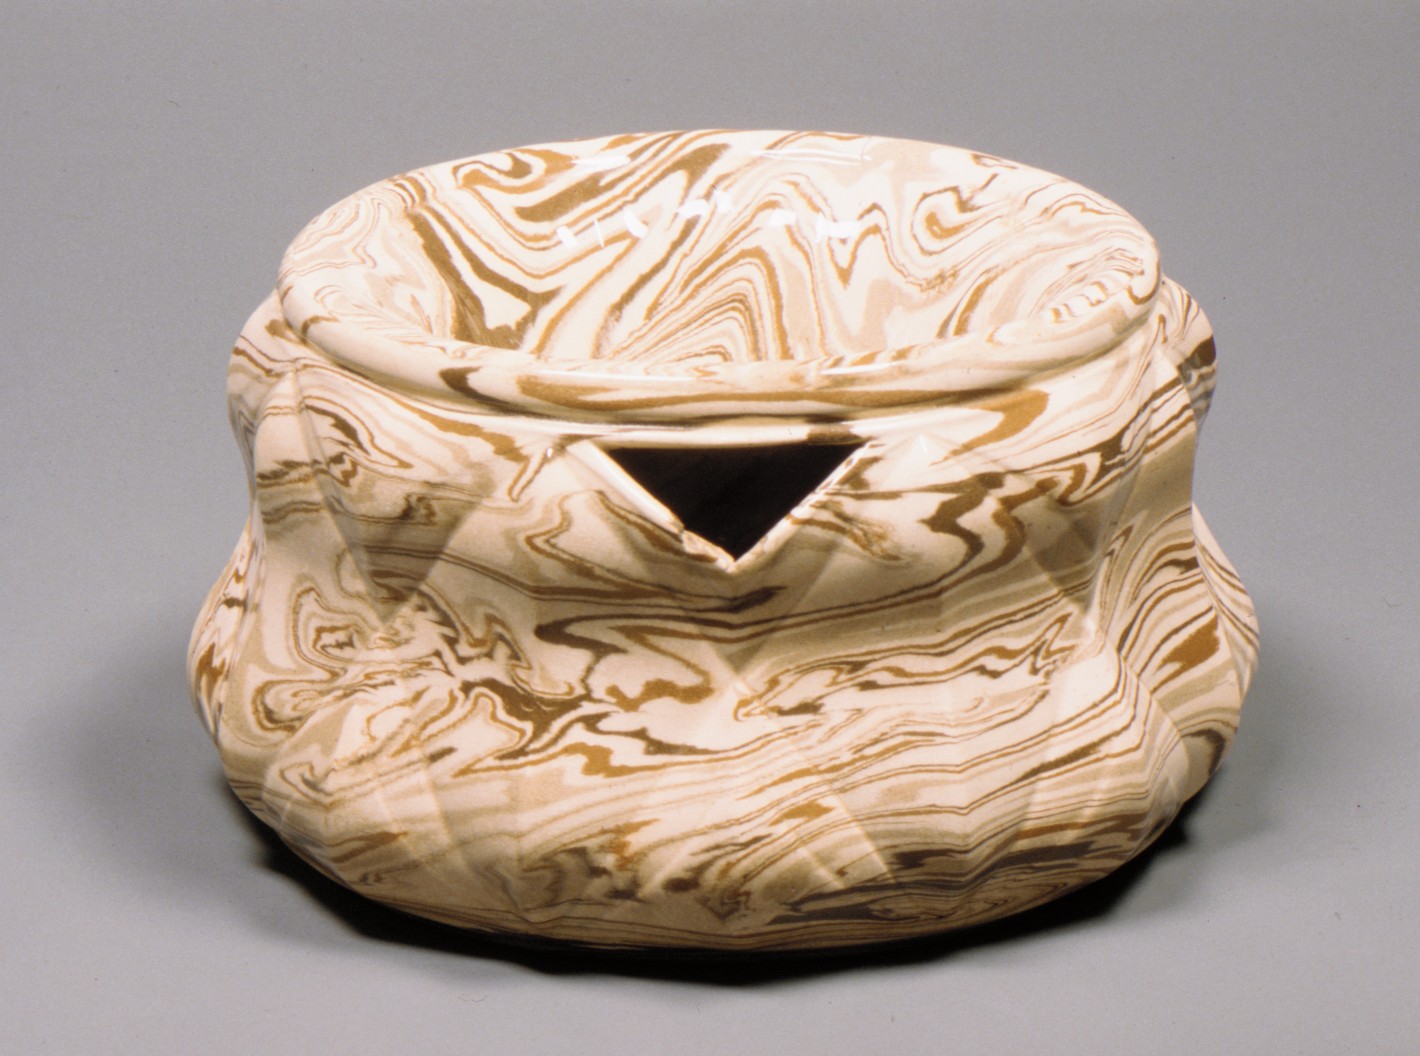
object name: cuspidor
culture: american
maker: united states pottery company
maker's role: maker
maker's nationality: american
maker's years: 1852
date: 1849-1856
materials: earthenware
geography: united states